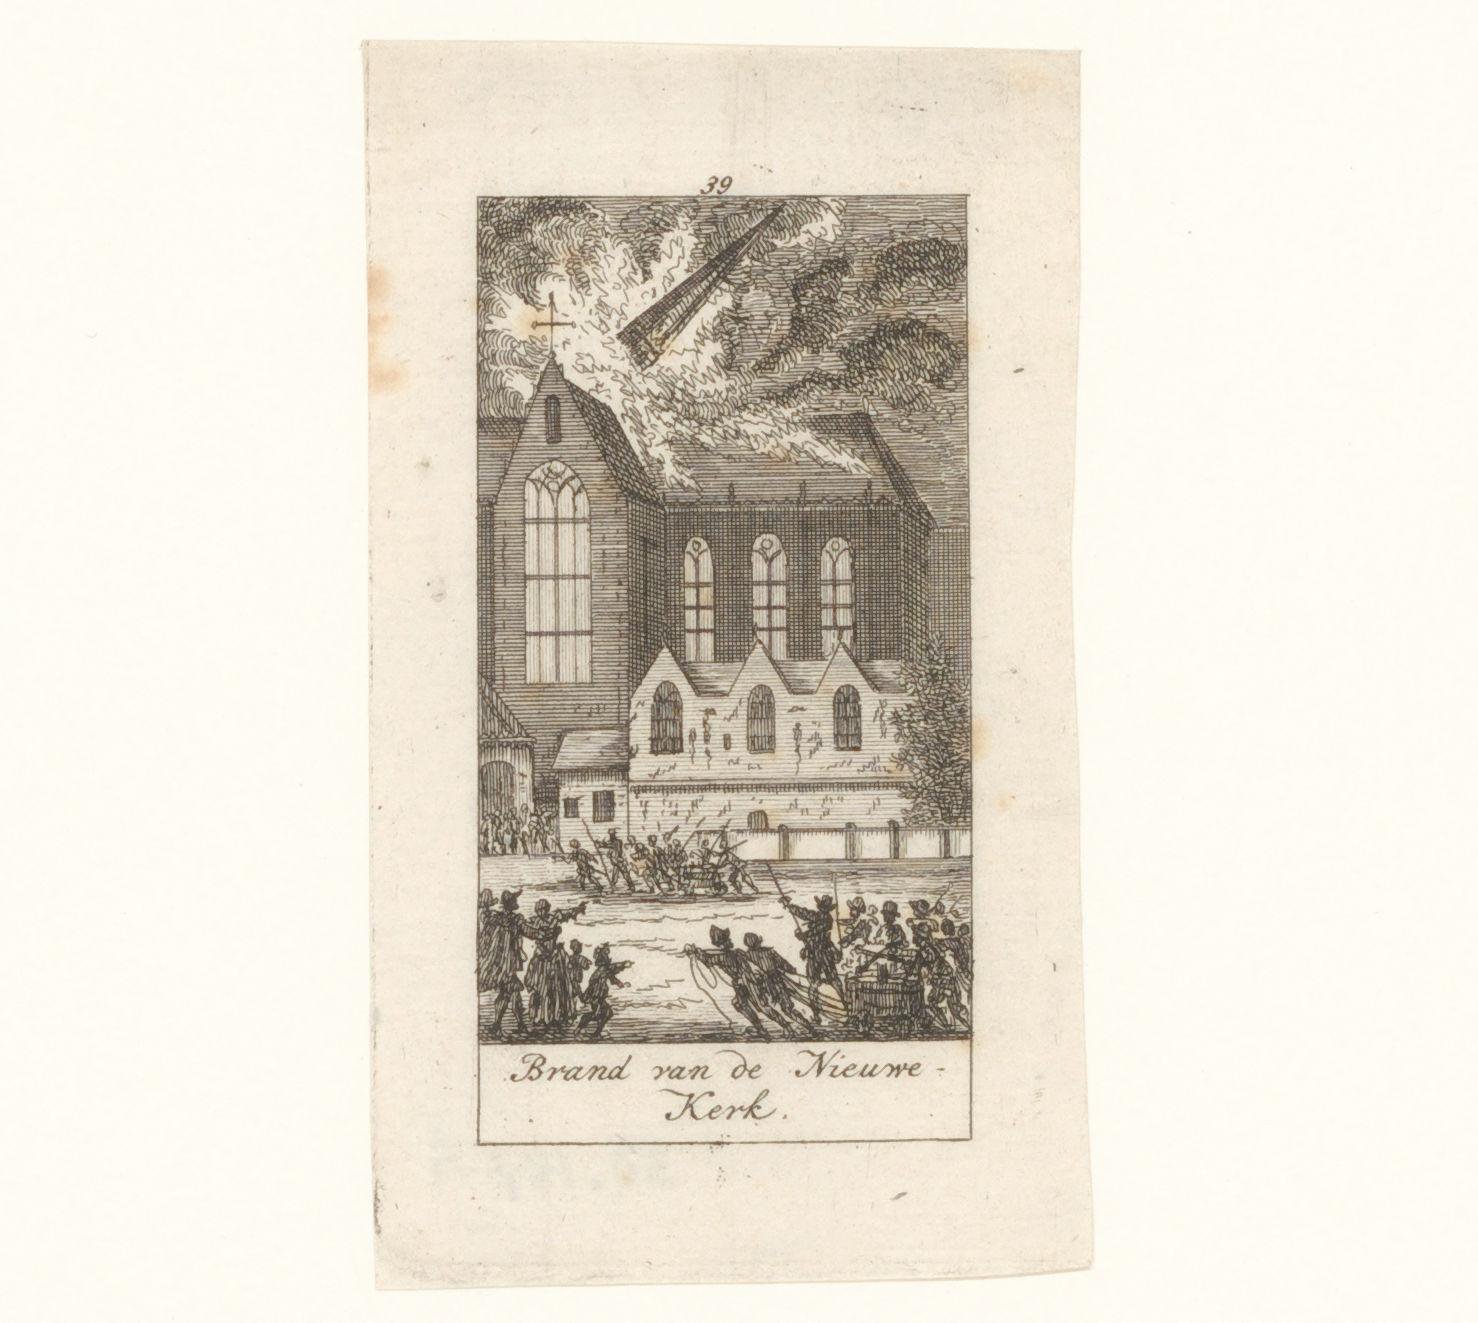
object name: print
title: Brand van de Nieuwe Kerk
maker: simon fokke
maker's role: draughtsman, print maker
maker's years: 1712-1784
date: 1722-1784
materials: paper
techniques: engraving, etching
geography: amsterdam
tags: on fire, ablaze, church (exterior)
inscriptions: collector's mark: Lugt 1641b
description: Centraal bovenaan genummerd: 39. Onderwerpsrubriek binnen de Atlas Amsterdam: Kerkwezen: Hervormde Gemeente: Nieuwe Kerk, de brand van 1645.